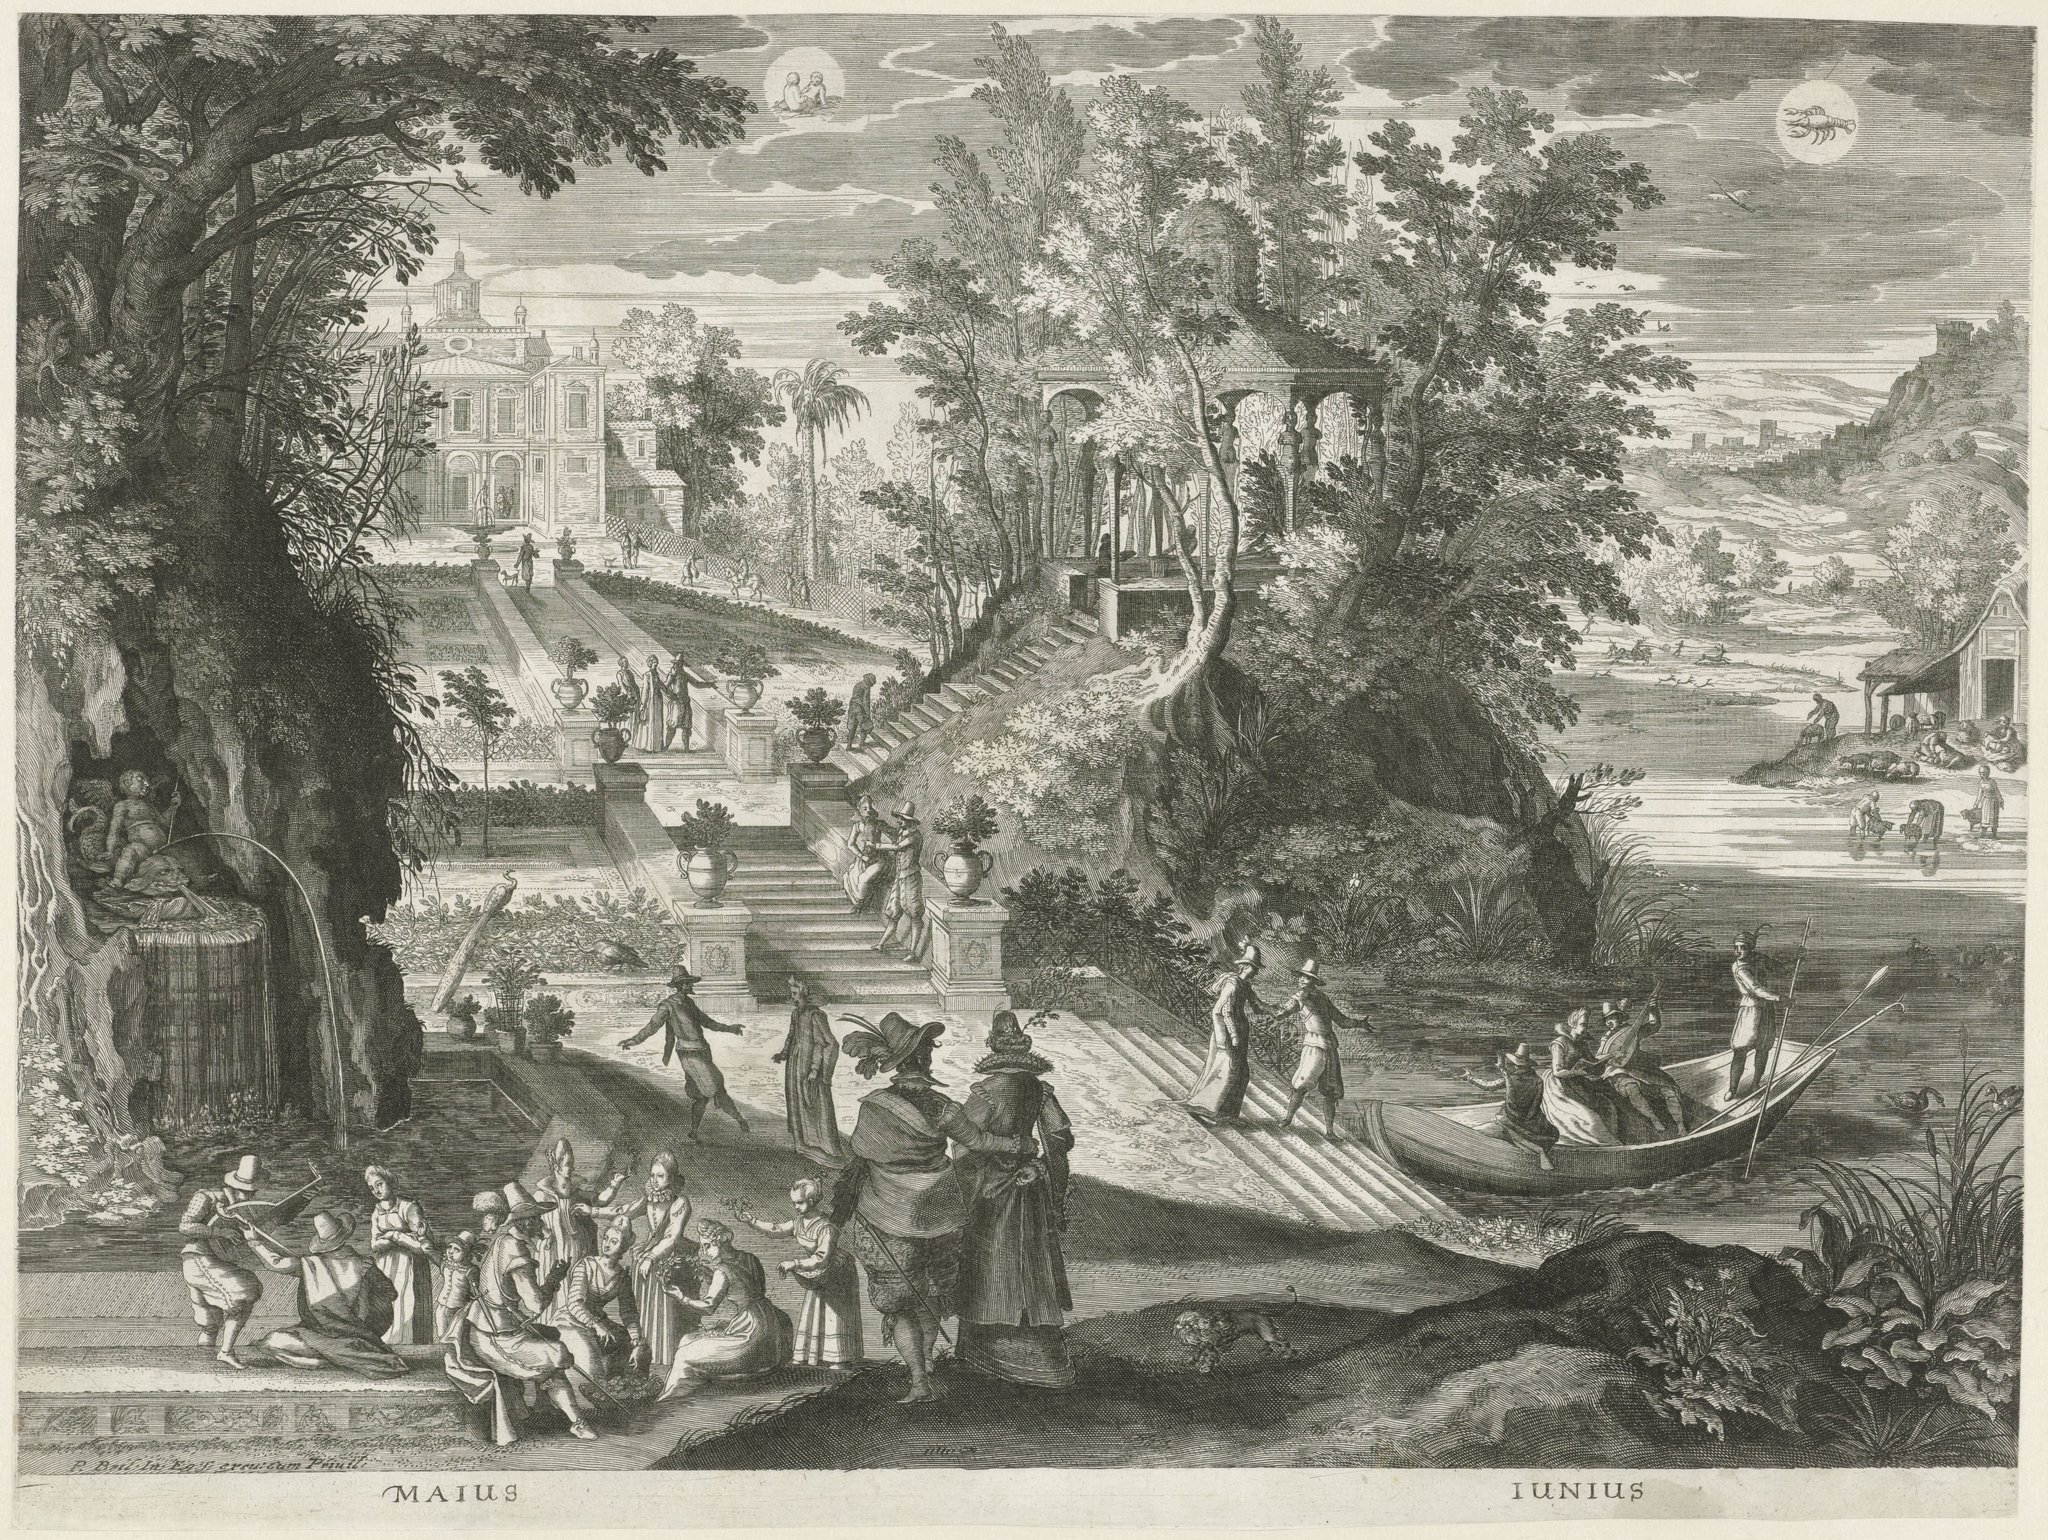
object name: print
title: Mei en juni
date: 1615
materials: paper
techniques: engraving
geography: prague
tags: rowing facing forward, pushing, landscape symbolizing june (+ with zodiacal signs), landscape symbolizing may (+ with zodiacal signs), garden fountain, clothes, costume (+ women's clothes), clothes, costume (+ men's clothes), outdoor gathering, 'délices à la campagne', may and its 'labours' (+ with zodiacal signs), june and its 'labours' (+ with zodiacal signs), belvedere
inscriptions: collector's mark: Lugt 240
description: Italiaans landschap tijdens de maanden mei en juni. Op de voorgrond links een fontein waarbij een elegant gezelschap muziek maakt, danst, converseert en bloemenkransen vlecht. In het midden op een heuveltje een theekoepel met karyatiden. Rechst een rivier met op de voorgrond een elegant gezelschap in een roeiboot. Op het tweede plan herders die hun schapen wassen in de rivier alvorens ze te scheren. Een jachttafereel op de achtergrond. Bovenaan links en rechts de tekens van de zodiak: het sterrenbeeld Tweeling en het sterrenbeeld Kreeft.